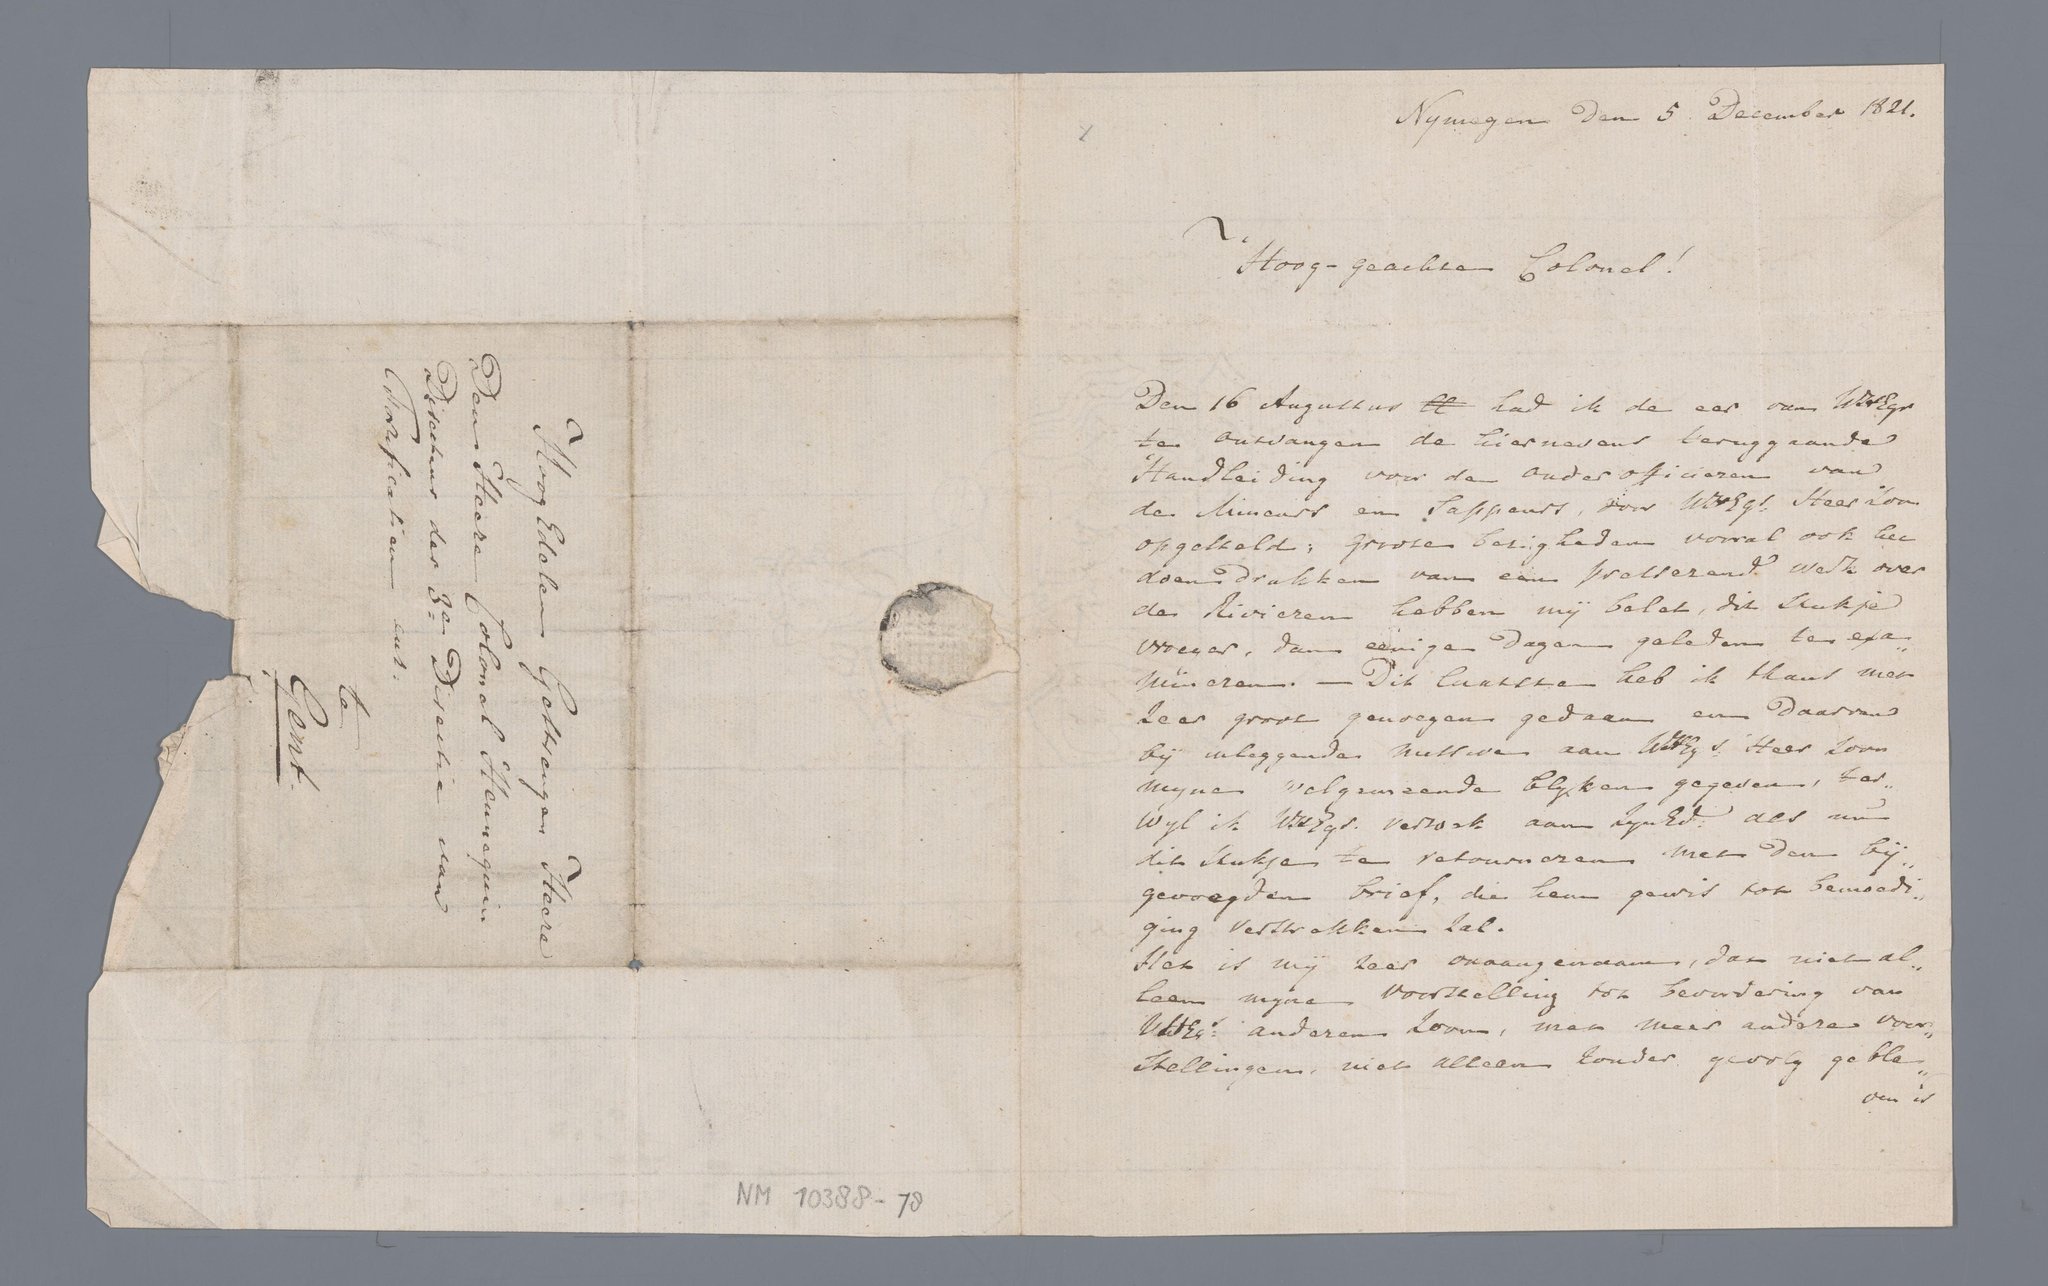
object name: letter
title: Brief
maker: cornelis rudolphus theodorus krayenhoff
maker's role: physicist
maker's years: 1758-1840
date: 1821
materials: ink, paper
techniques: writing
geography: nijmegen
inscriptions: date